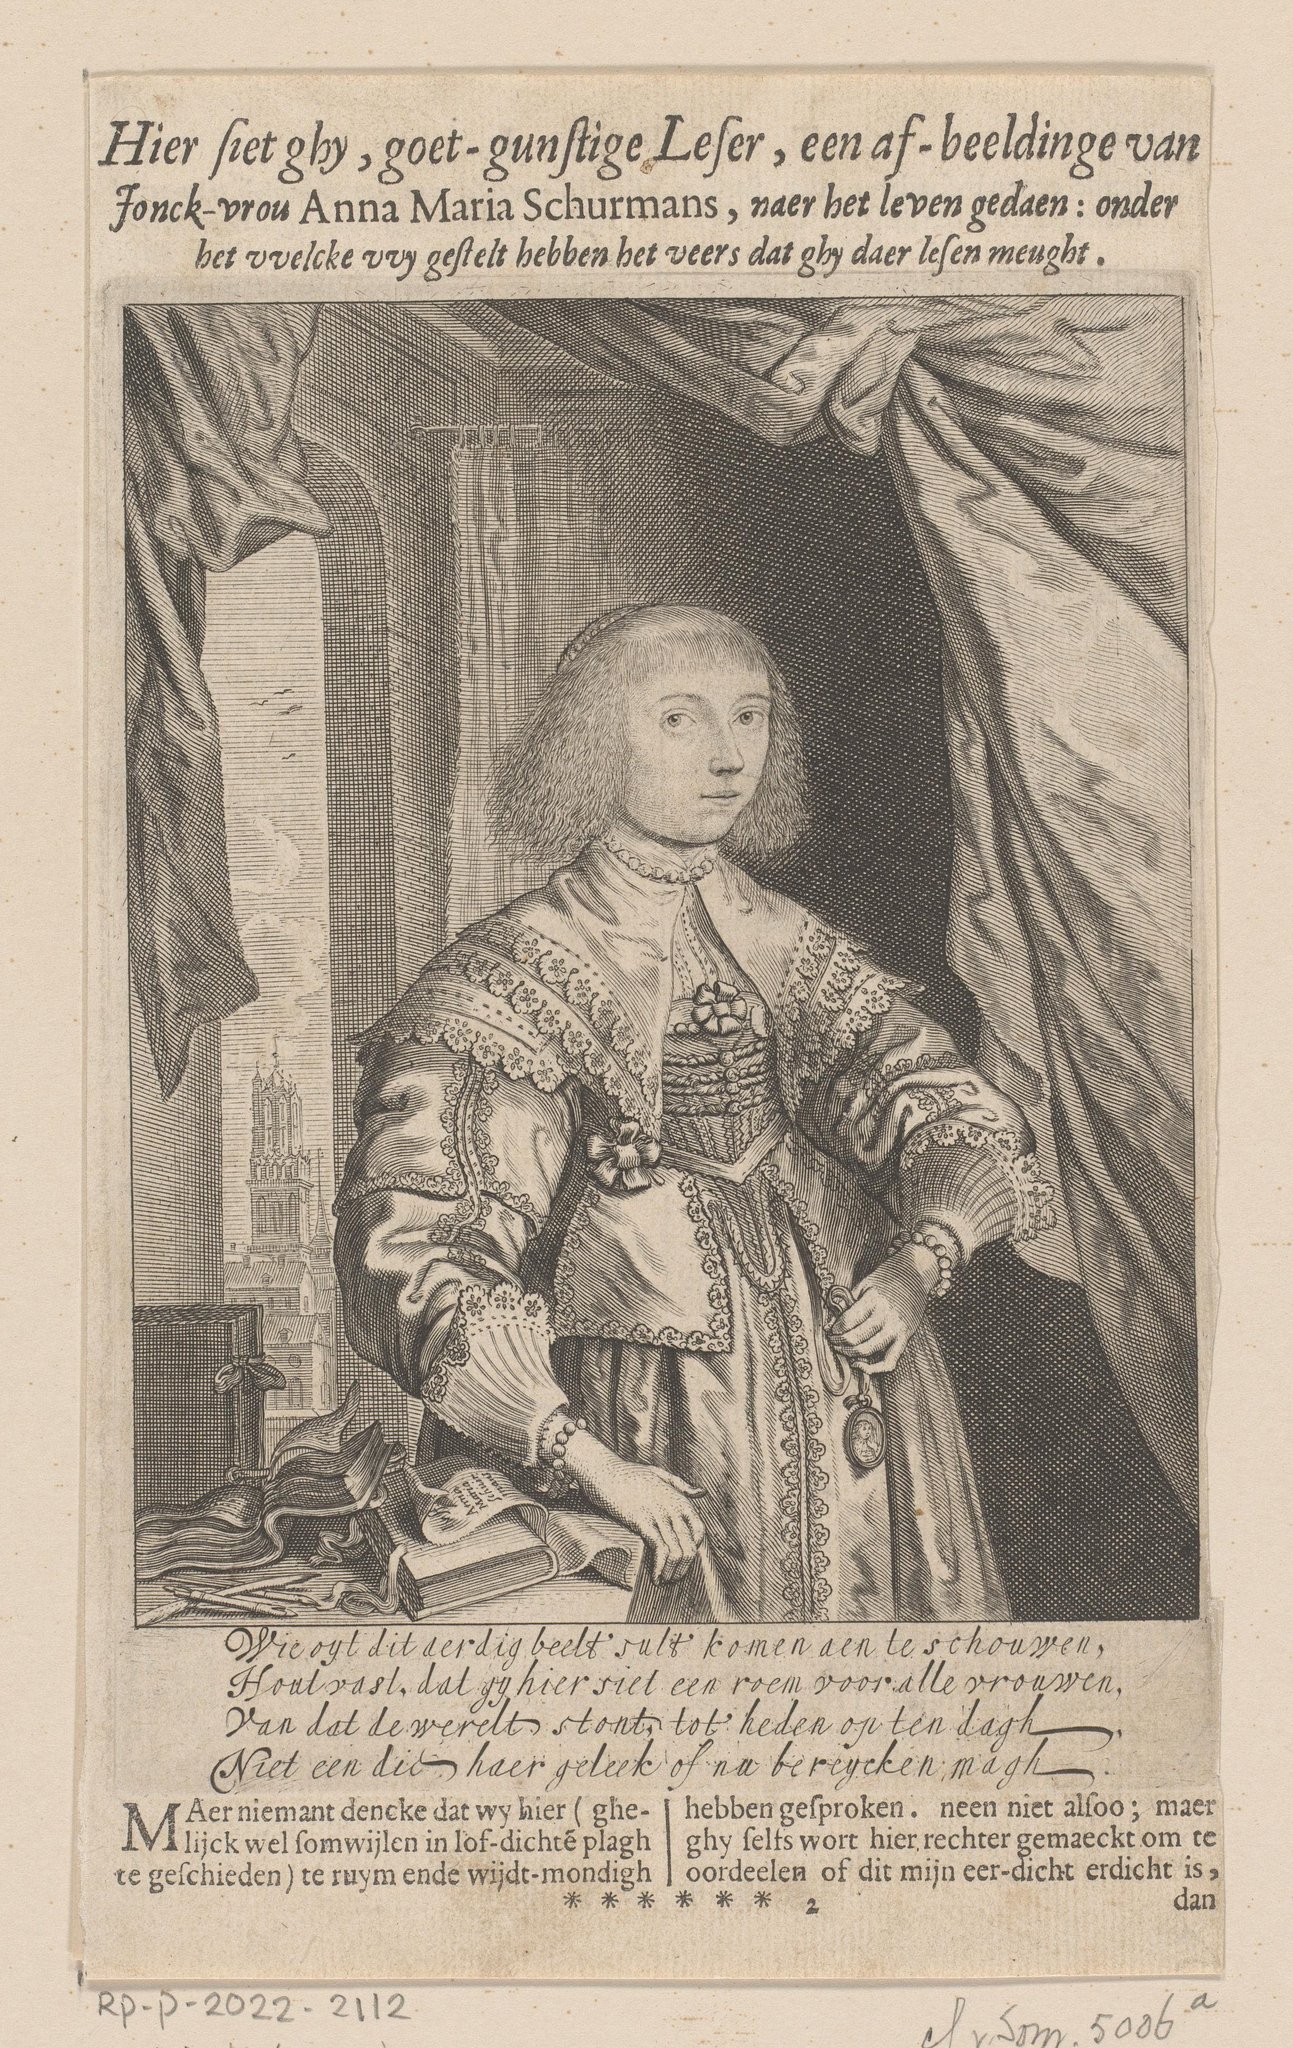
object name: book illustration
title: Portret van Anna Maria van Schurman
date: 1637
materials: paper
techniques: engraving, etching, letterpress printing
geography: dordrecht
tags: cologne, anna maria van schurman, historical persons - bb - woman, portrait, self-portrait of artist, writer, poet, author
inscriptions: collector's mark: Lugt 2228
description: Prent uit: Cats, Jacob. 's Werelts begin, midden, eynde, besloten in den trov-ringh (...). Dordrecht: Hendrick van Esch, 1637.